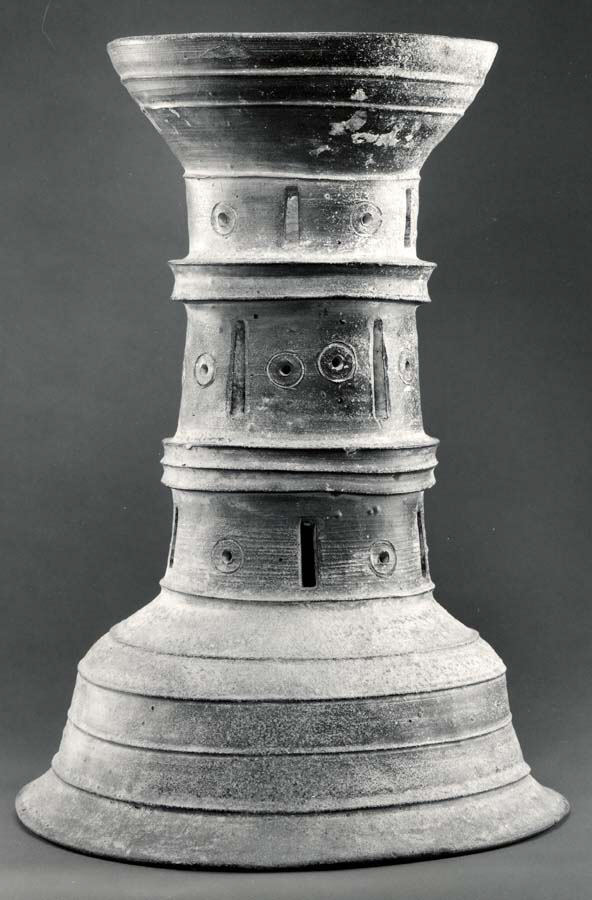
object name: stand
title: Tall perforated stand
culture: korean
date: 401-500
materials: stoneware